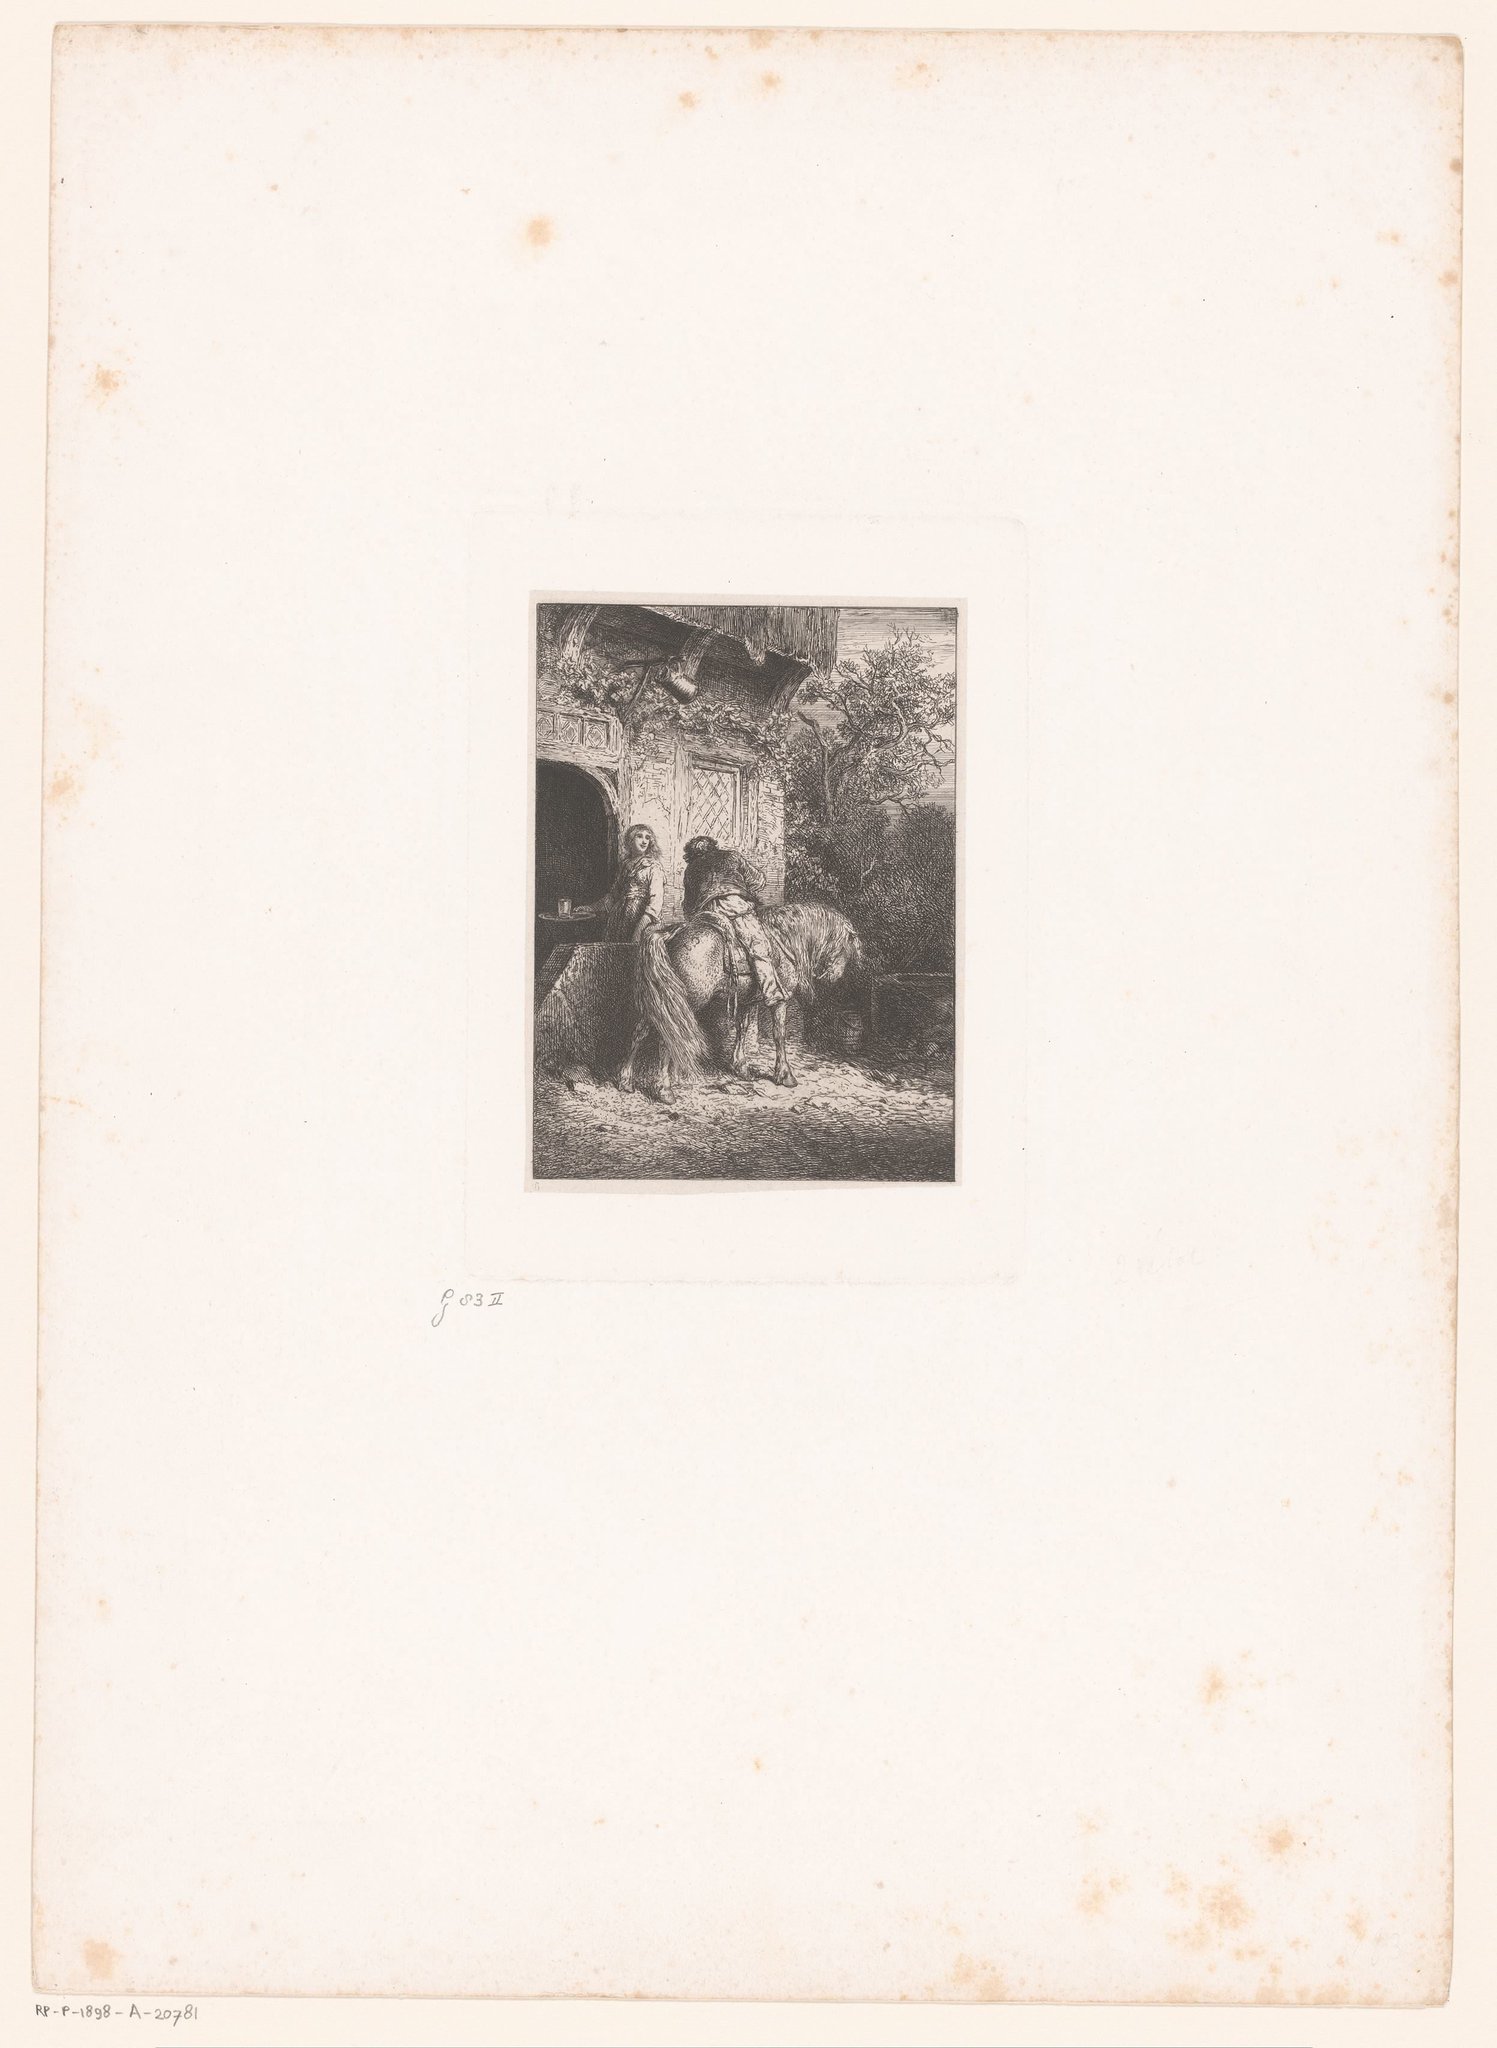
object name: print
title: Verschillende composities door Jacque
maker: charles emile jacque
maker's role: draughtsman, painter, print maker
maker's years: 1813-1894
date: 1845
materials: paper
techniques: drypoint, etching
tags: riding a horse, ass, or mule; rider, horseman, hotel, hostelry, inn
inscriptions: collector's mark: Lugt 964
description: Maakt deel uit van een twintigdelige serie met verschillende onderwerpen door Jacque.